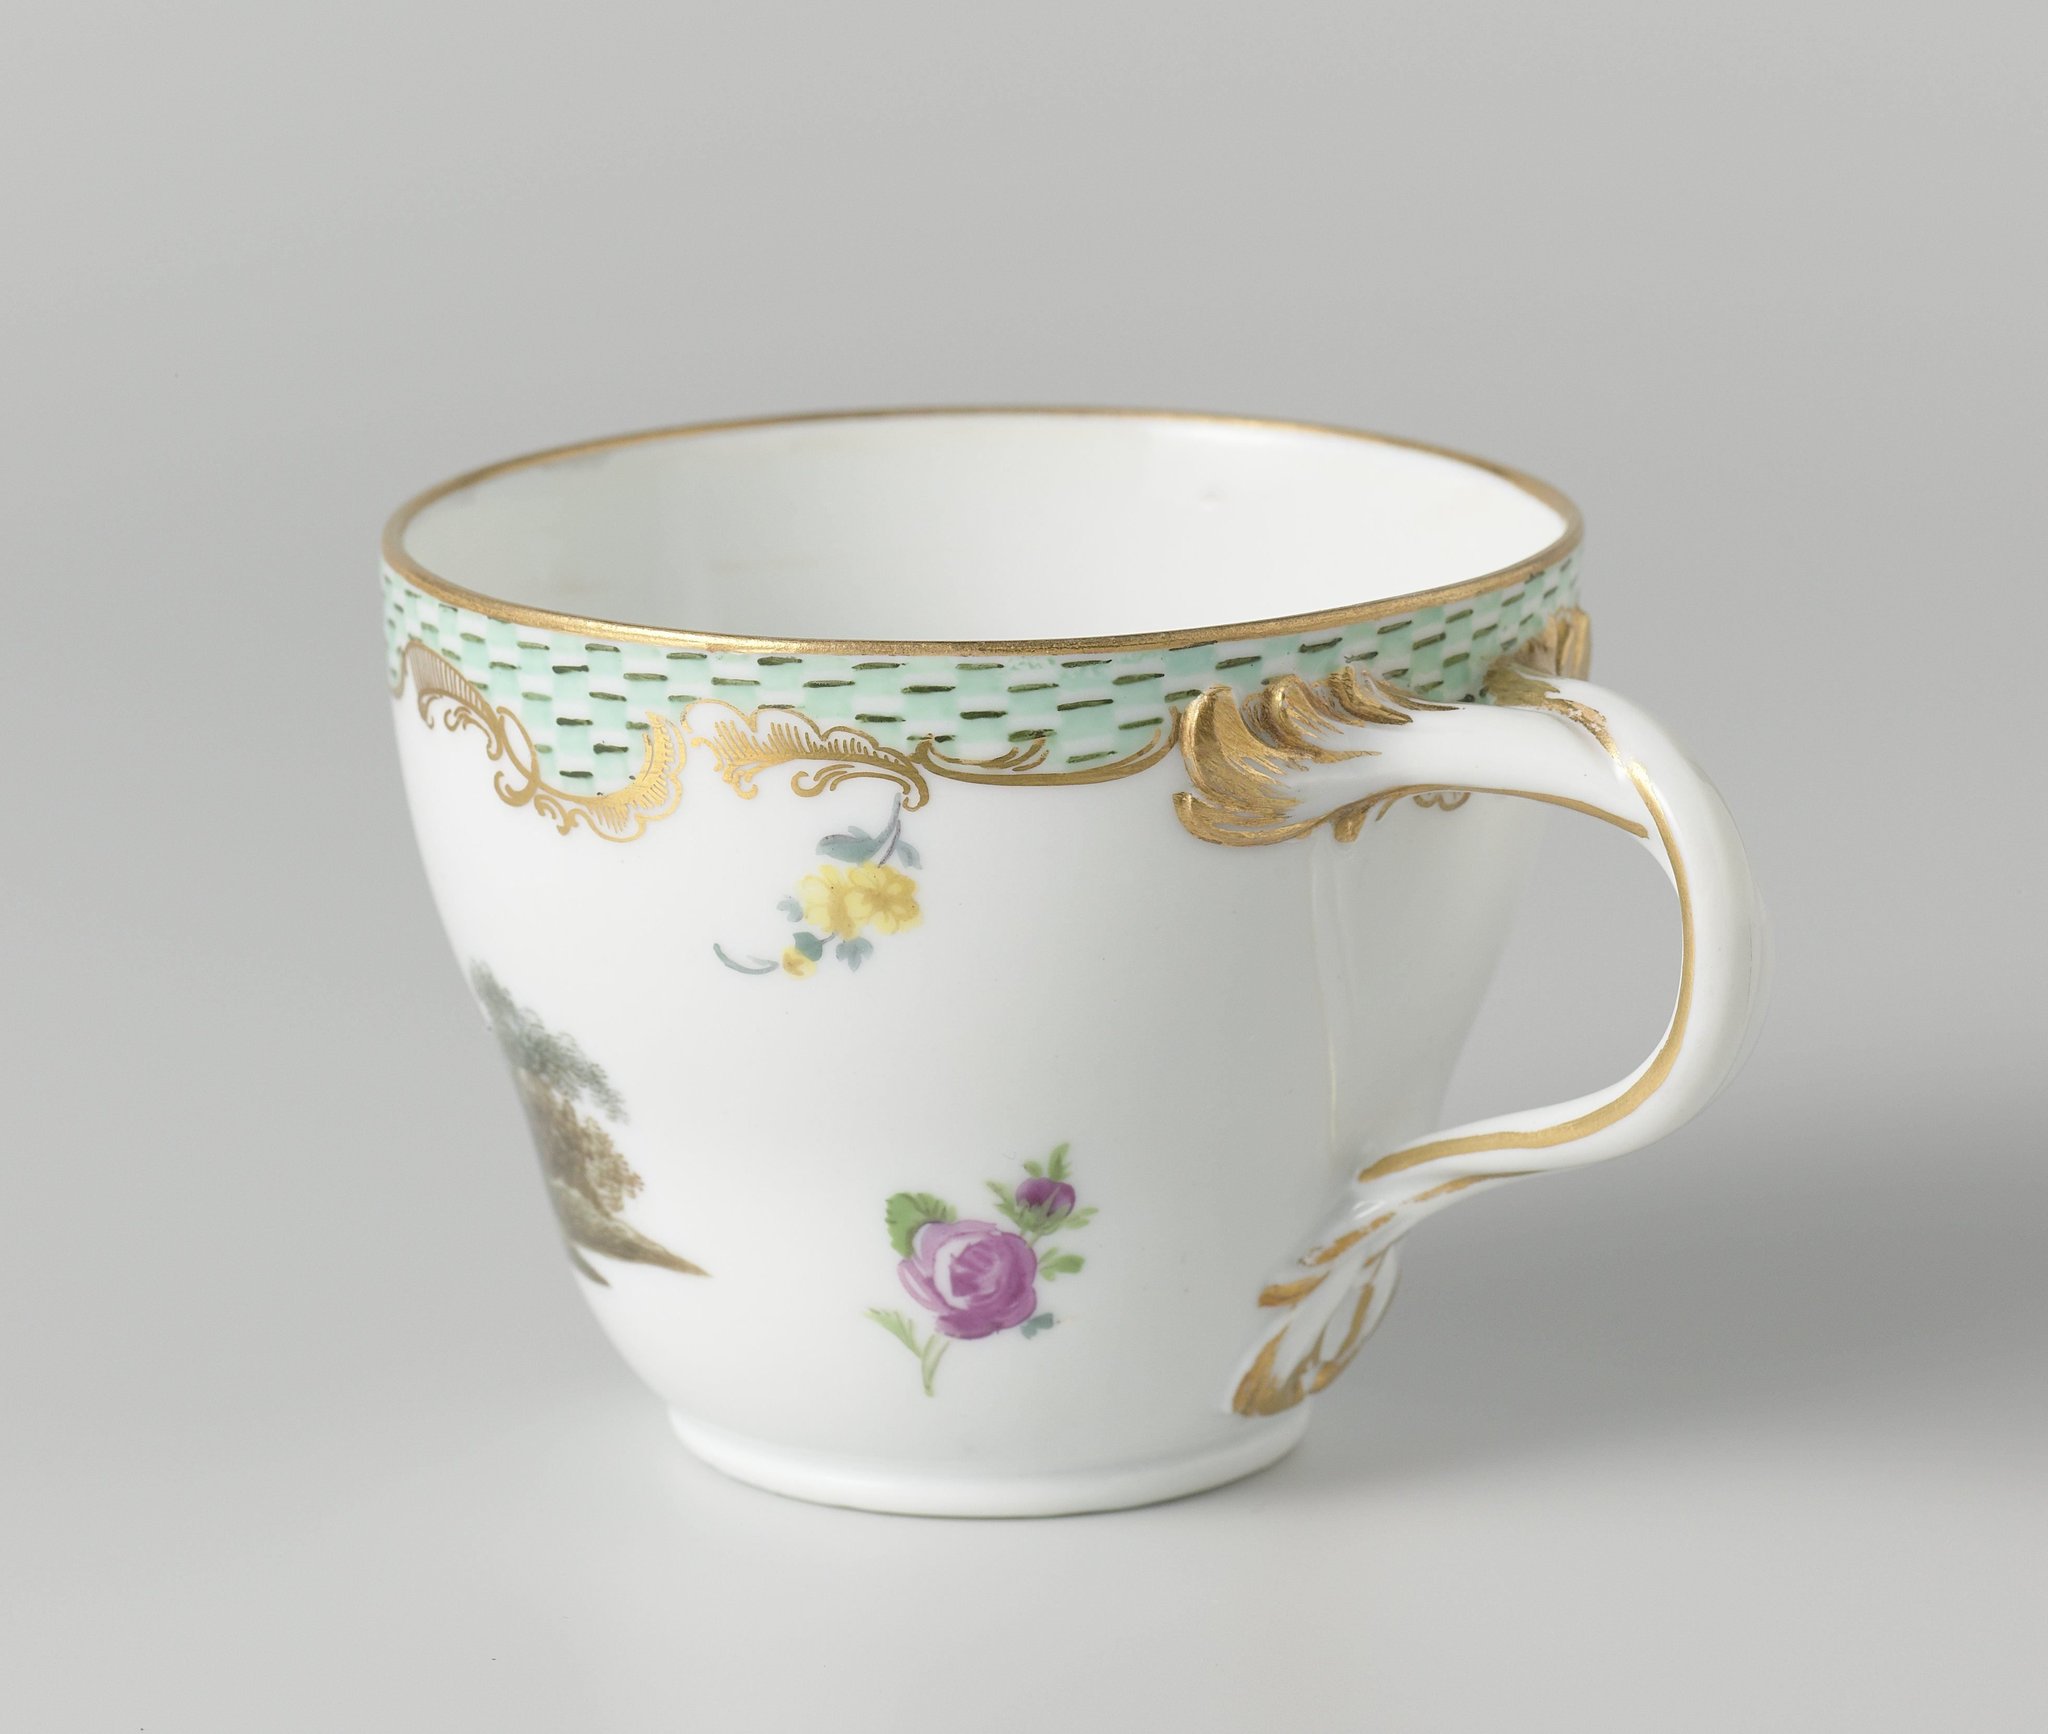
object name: pattipan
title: Kop, veelkleurig beschilderd met een landschap met figuren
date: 1777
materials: porcelain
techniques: painted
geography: meissen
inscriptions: factory mark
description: Hoge kop met oor, van beschilderd porselein. De kop is beschilderd met landschappen waarin figuren en langs de rand een brede strook groen vlechtwerk. De kop is gemerkt.